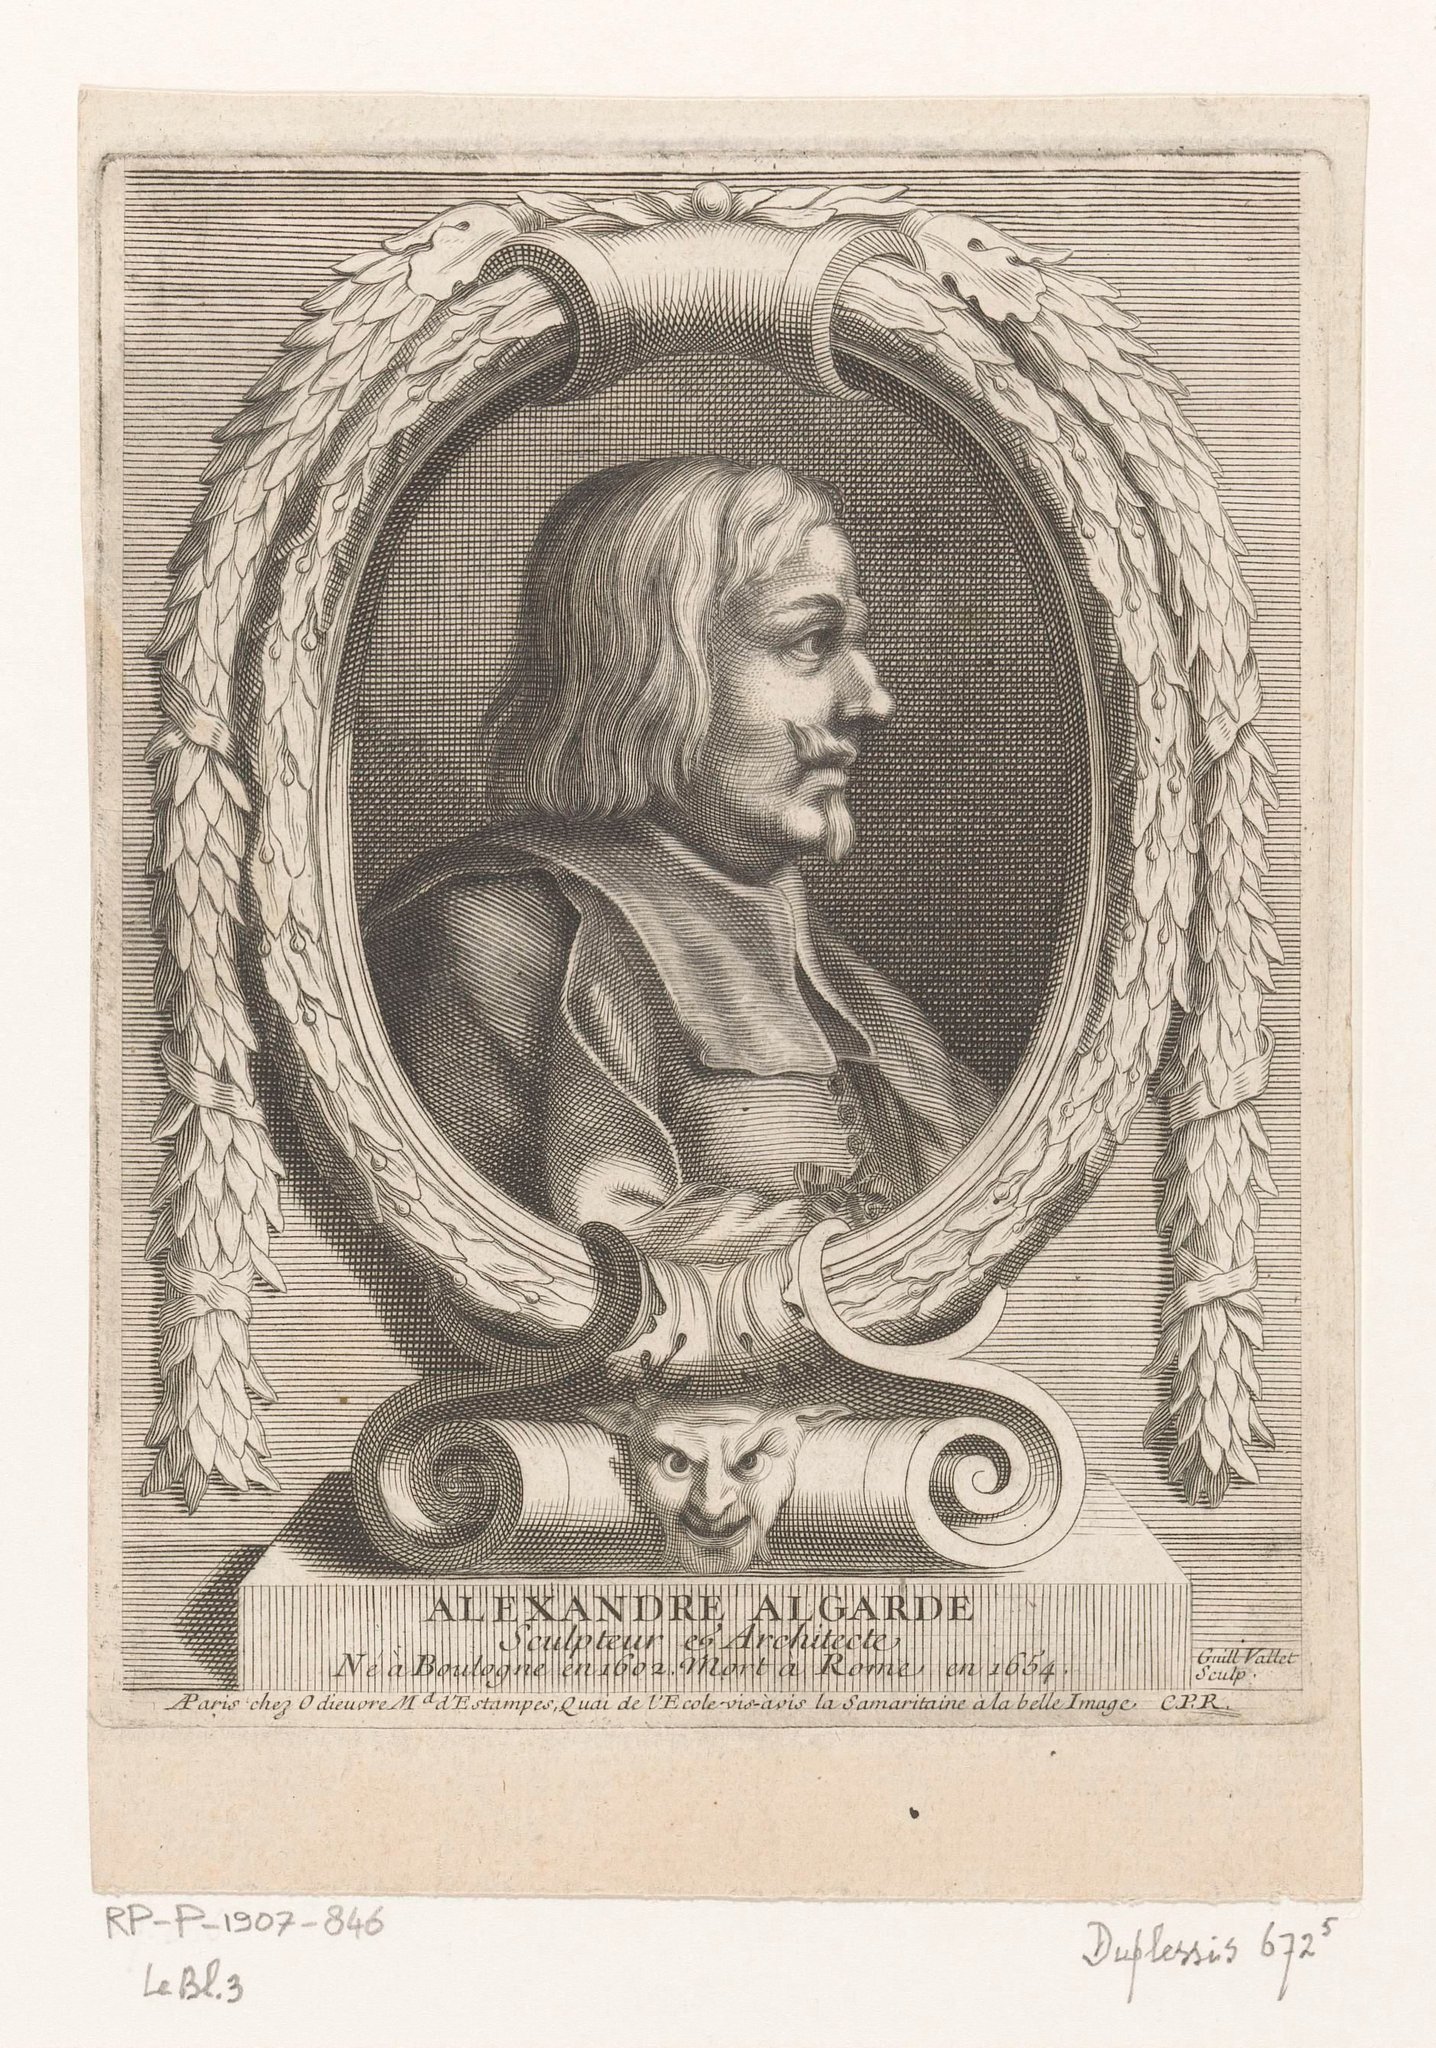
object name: print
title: Alexandre Algarde (...)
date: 1697-1704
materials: paper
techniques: engraving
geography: paris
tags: rome, draughtsman, sculptor, alessandro algardi, portrait, self-portrait of sculptor, historical persons, portrait, self-portrait of architect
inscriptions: collector's mark: Lugt 2228